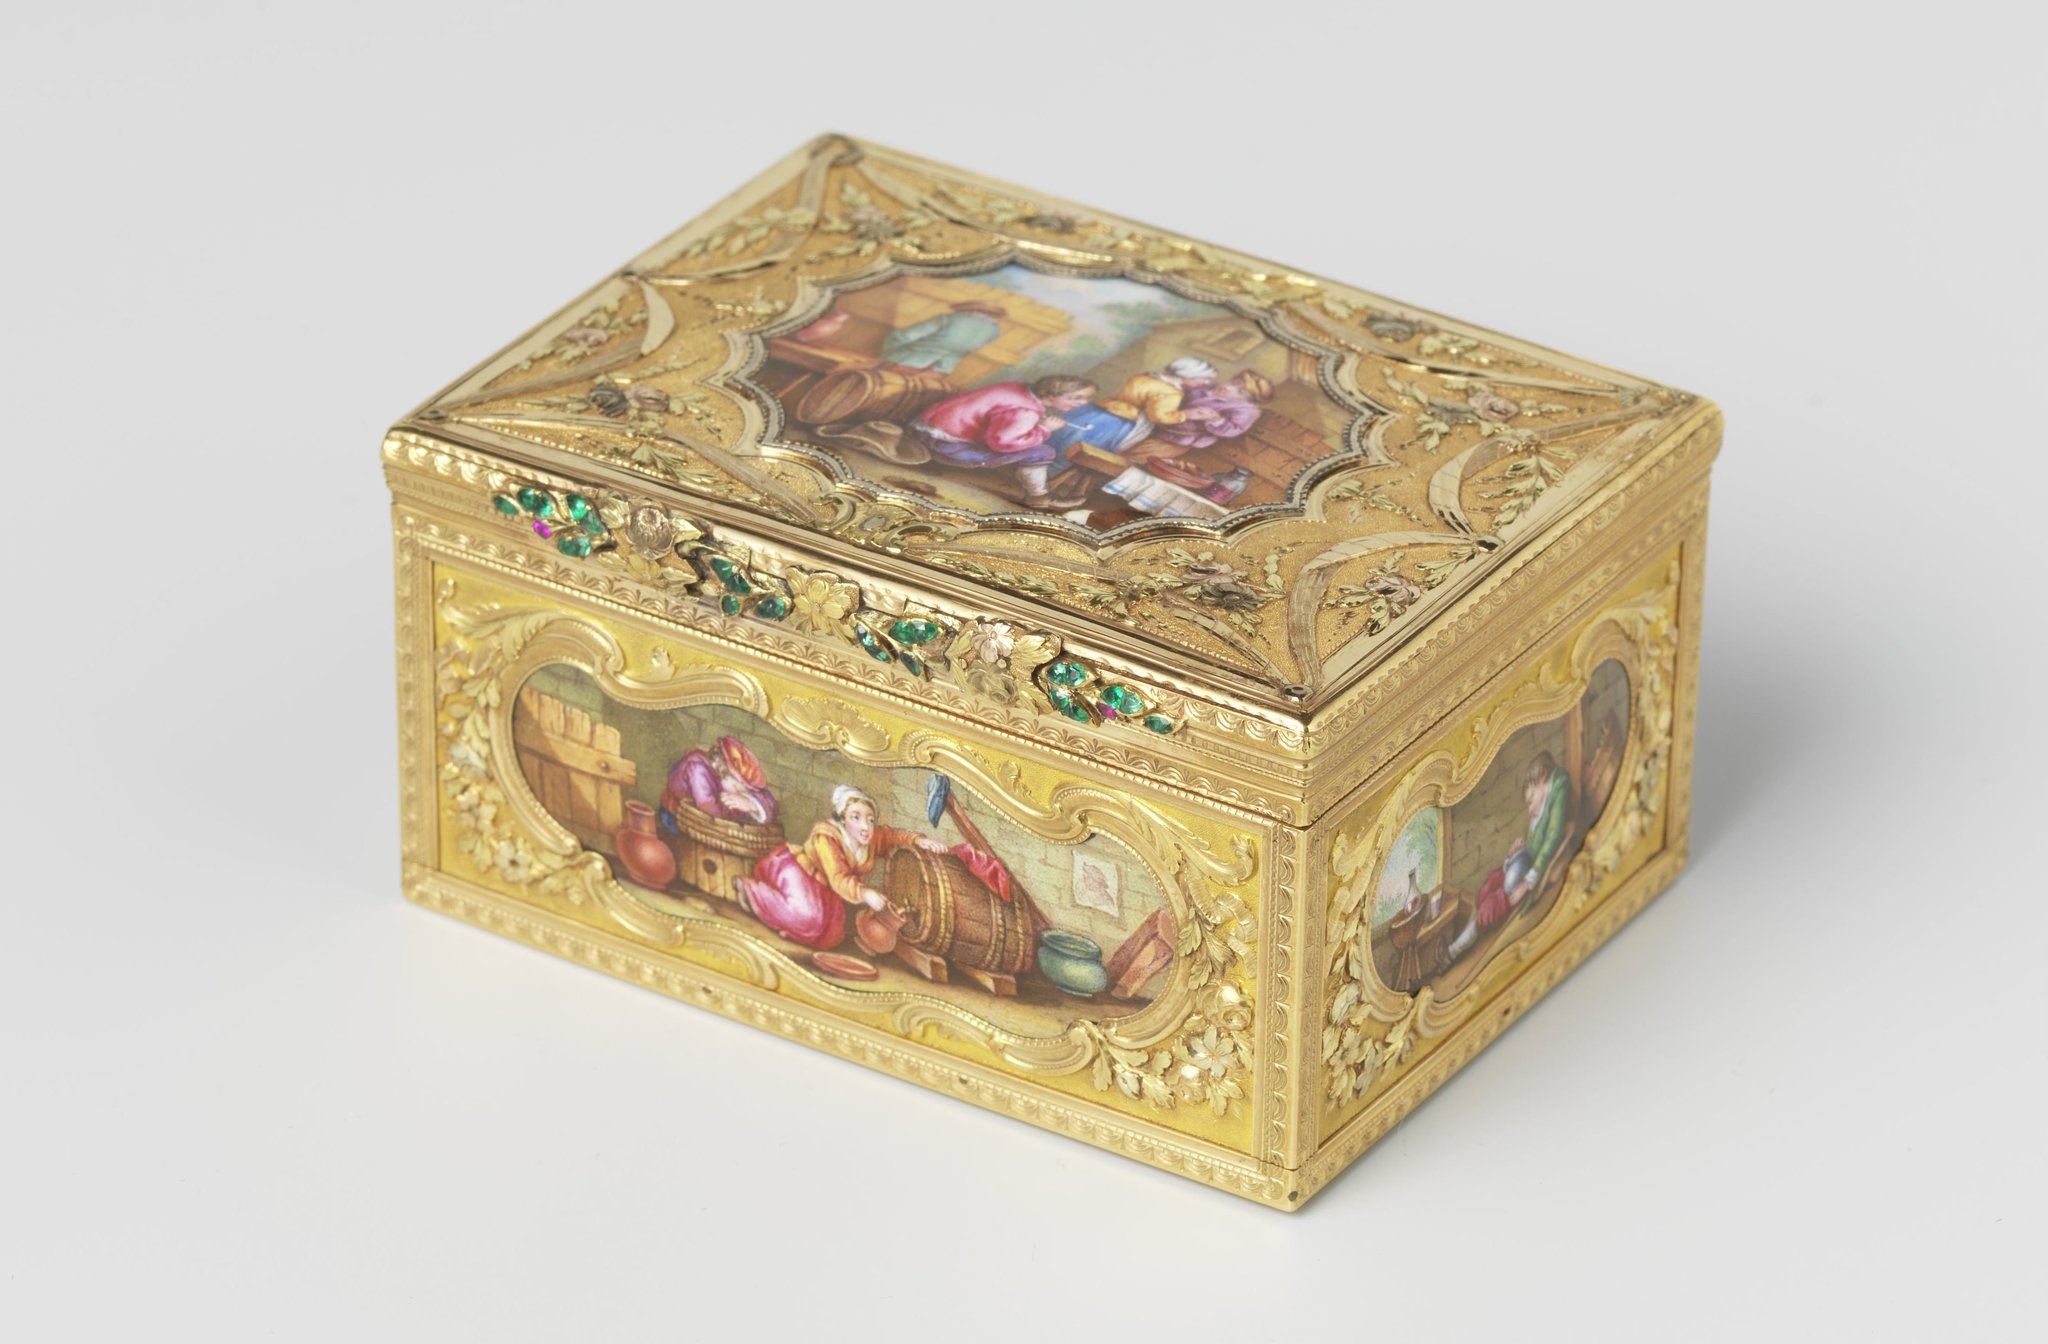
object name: snuffbox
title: Snuifdoos van goud, rechthoekig, versierd met zes herbergscènes in émail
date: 1758-1760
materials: gemstone, gold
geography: paris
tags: inn, coffee-house, public house, etc., pipe ~ tobacco, sleeping; unconsciousness, drinking, couple of lovers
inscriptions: duty mark, maker's mark, inscription: ‘I III’, date letter, duty mark: ‘V’, countermark, date letter, signature: ‘Ducrollay A Paris’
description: Snuffbox. Gold, enamel. Geneva (?) c. 1780. Snuffbox. Gold, enamel. Paris, 1759 - 1760, by Jean Ducrollay.